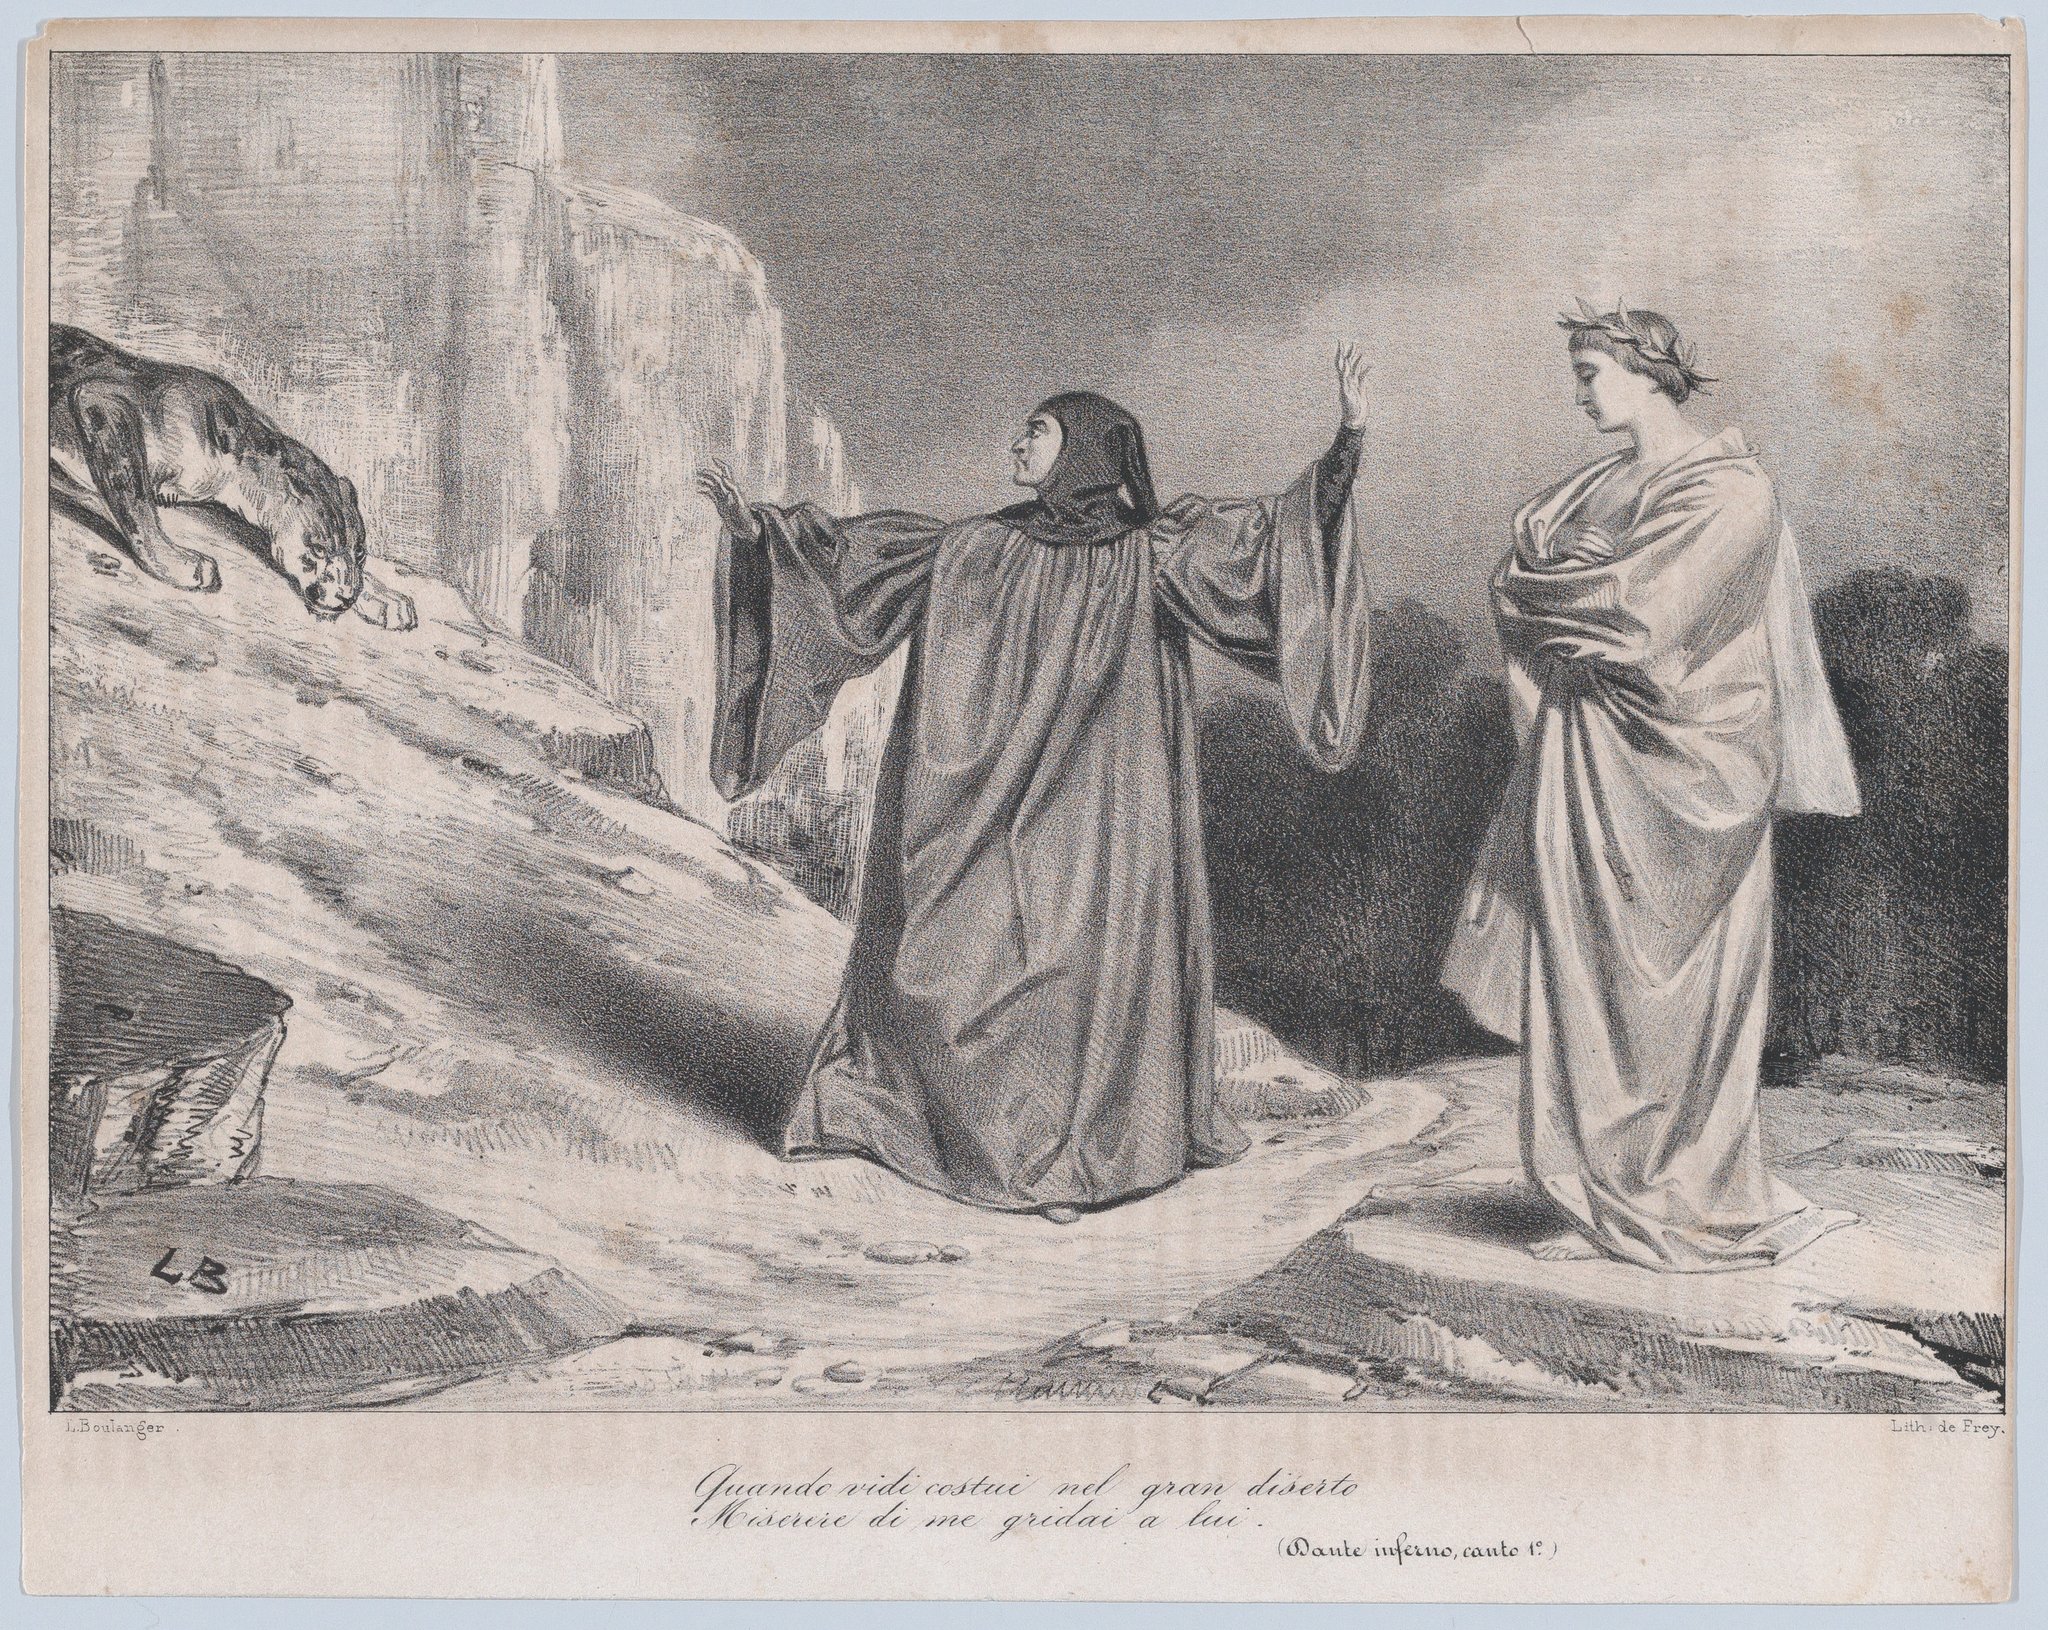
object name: print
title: Quando vidi costui nel gran diserte / Misere di me gridai a lui.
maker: louis boulanger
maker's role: artist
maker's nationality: french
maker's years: 1807-1867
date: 1835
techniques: lithograph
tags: women,tigers